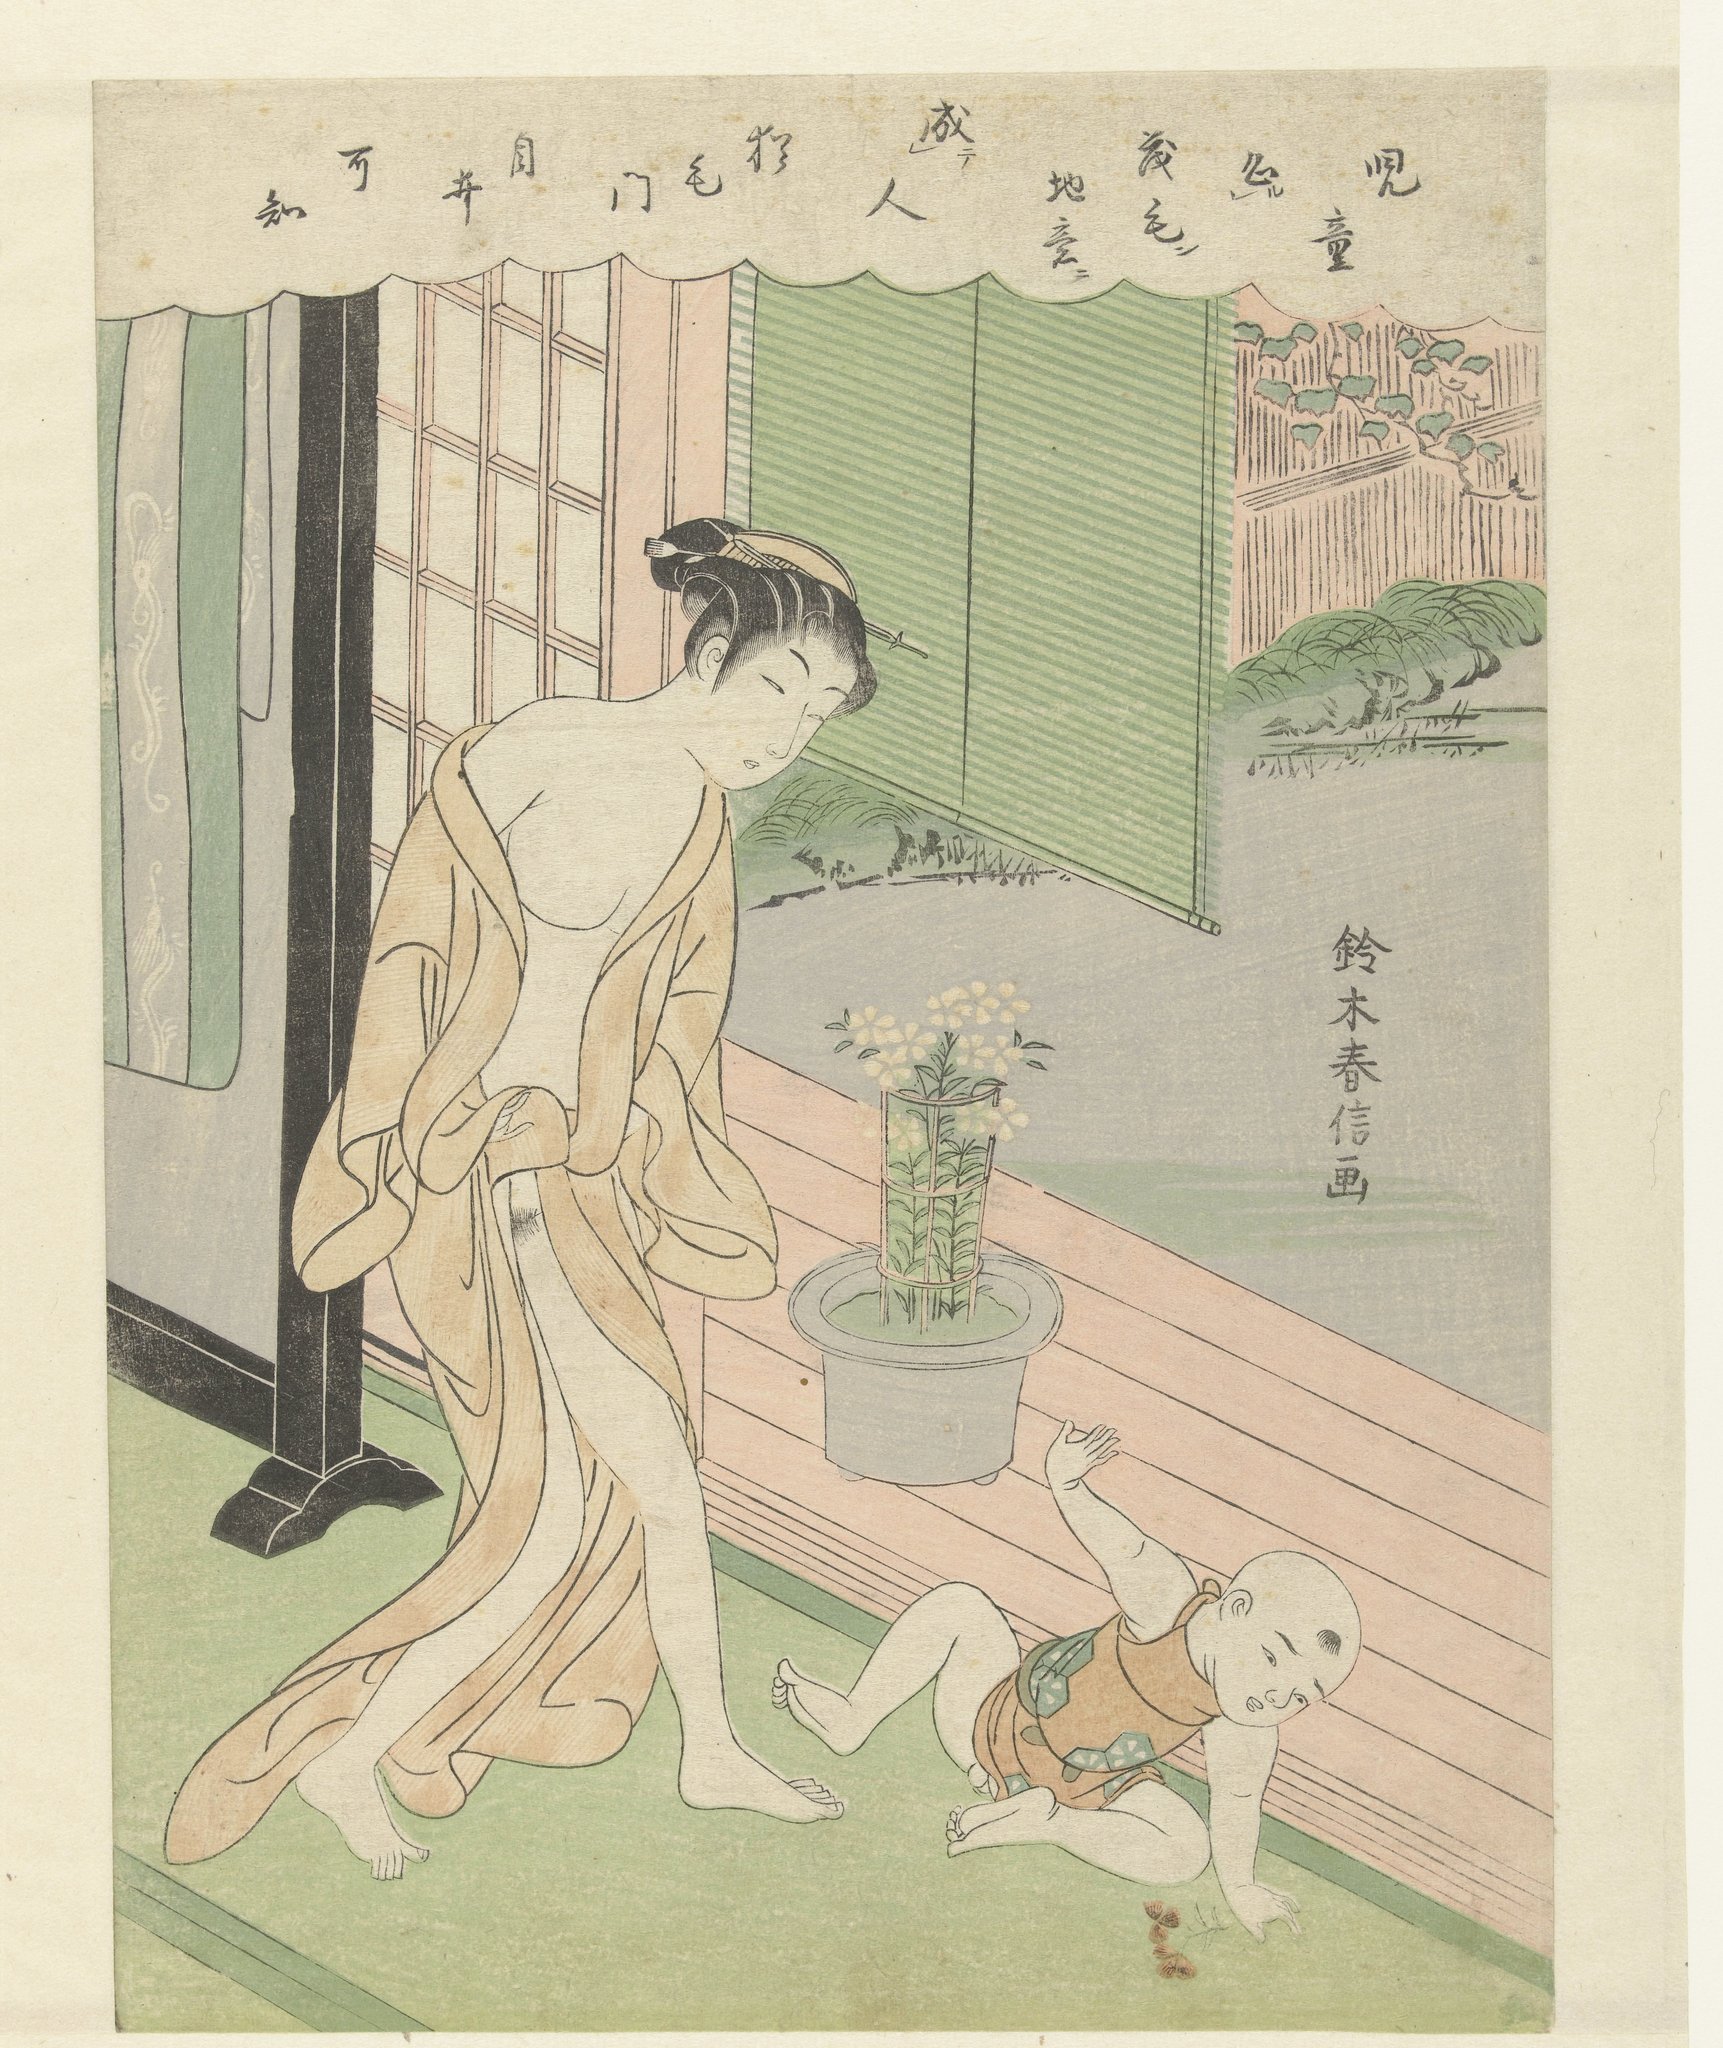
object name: print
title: Vrouw en ondeugend kind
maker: suzuki harunobu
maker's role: print maker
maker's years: 1725-1770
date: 1765-1770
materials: paper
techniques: woodcut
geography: japan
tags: adult woman, partially clothed, child (at home)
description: Naakte vrouw met openvallende ochtendjas, lopend naar kind zittend bij geplukte bloemen; op de veranda een pot met bloemen waarachter een gezicht op de tuin. Gedicht langs de bovenkant van de prent.